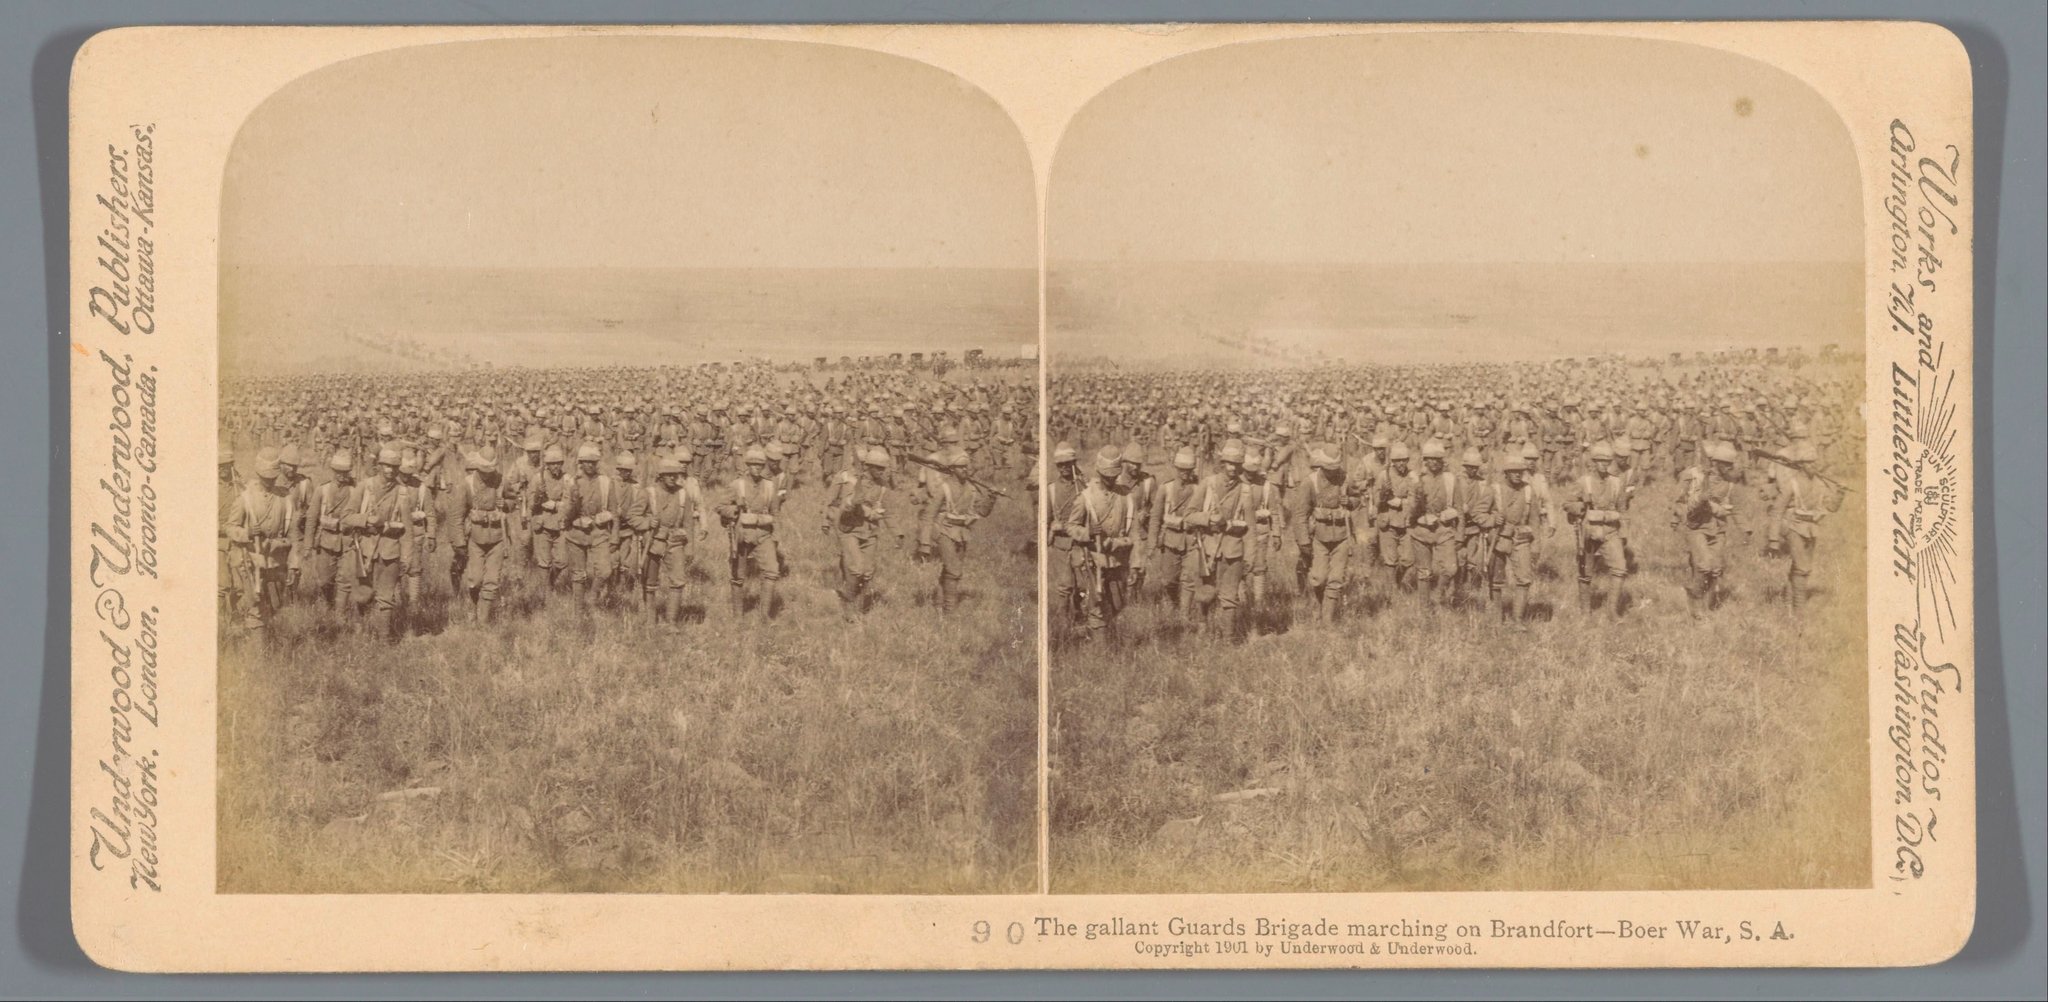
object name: stereograph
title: The gallant Guards Brigade marching on Brandfort - Boer War, S. Africa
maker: Anonymous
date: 1901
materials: cardboard, paper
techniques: albumen print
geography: new york city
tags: marching away (troops)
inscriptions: number: ‘90’, inscription, copyright notice: ‘Copyright 1901 by Underwood & Underwood.’, inscription: ‘Works and Studios ~/ Arlington, N.J. Littleton, N.H. Washington, D.C.’